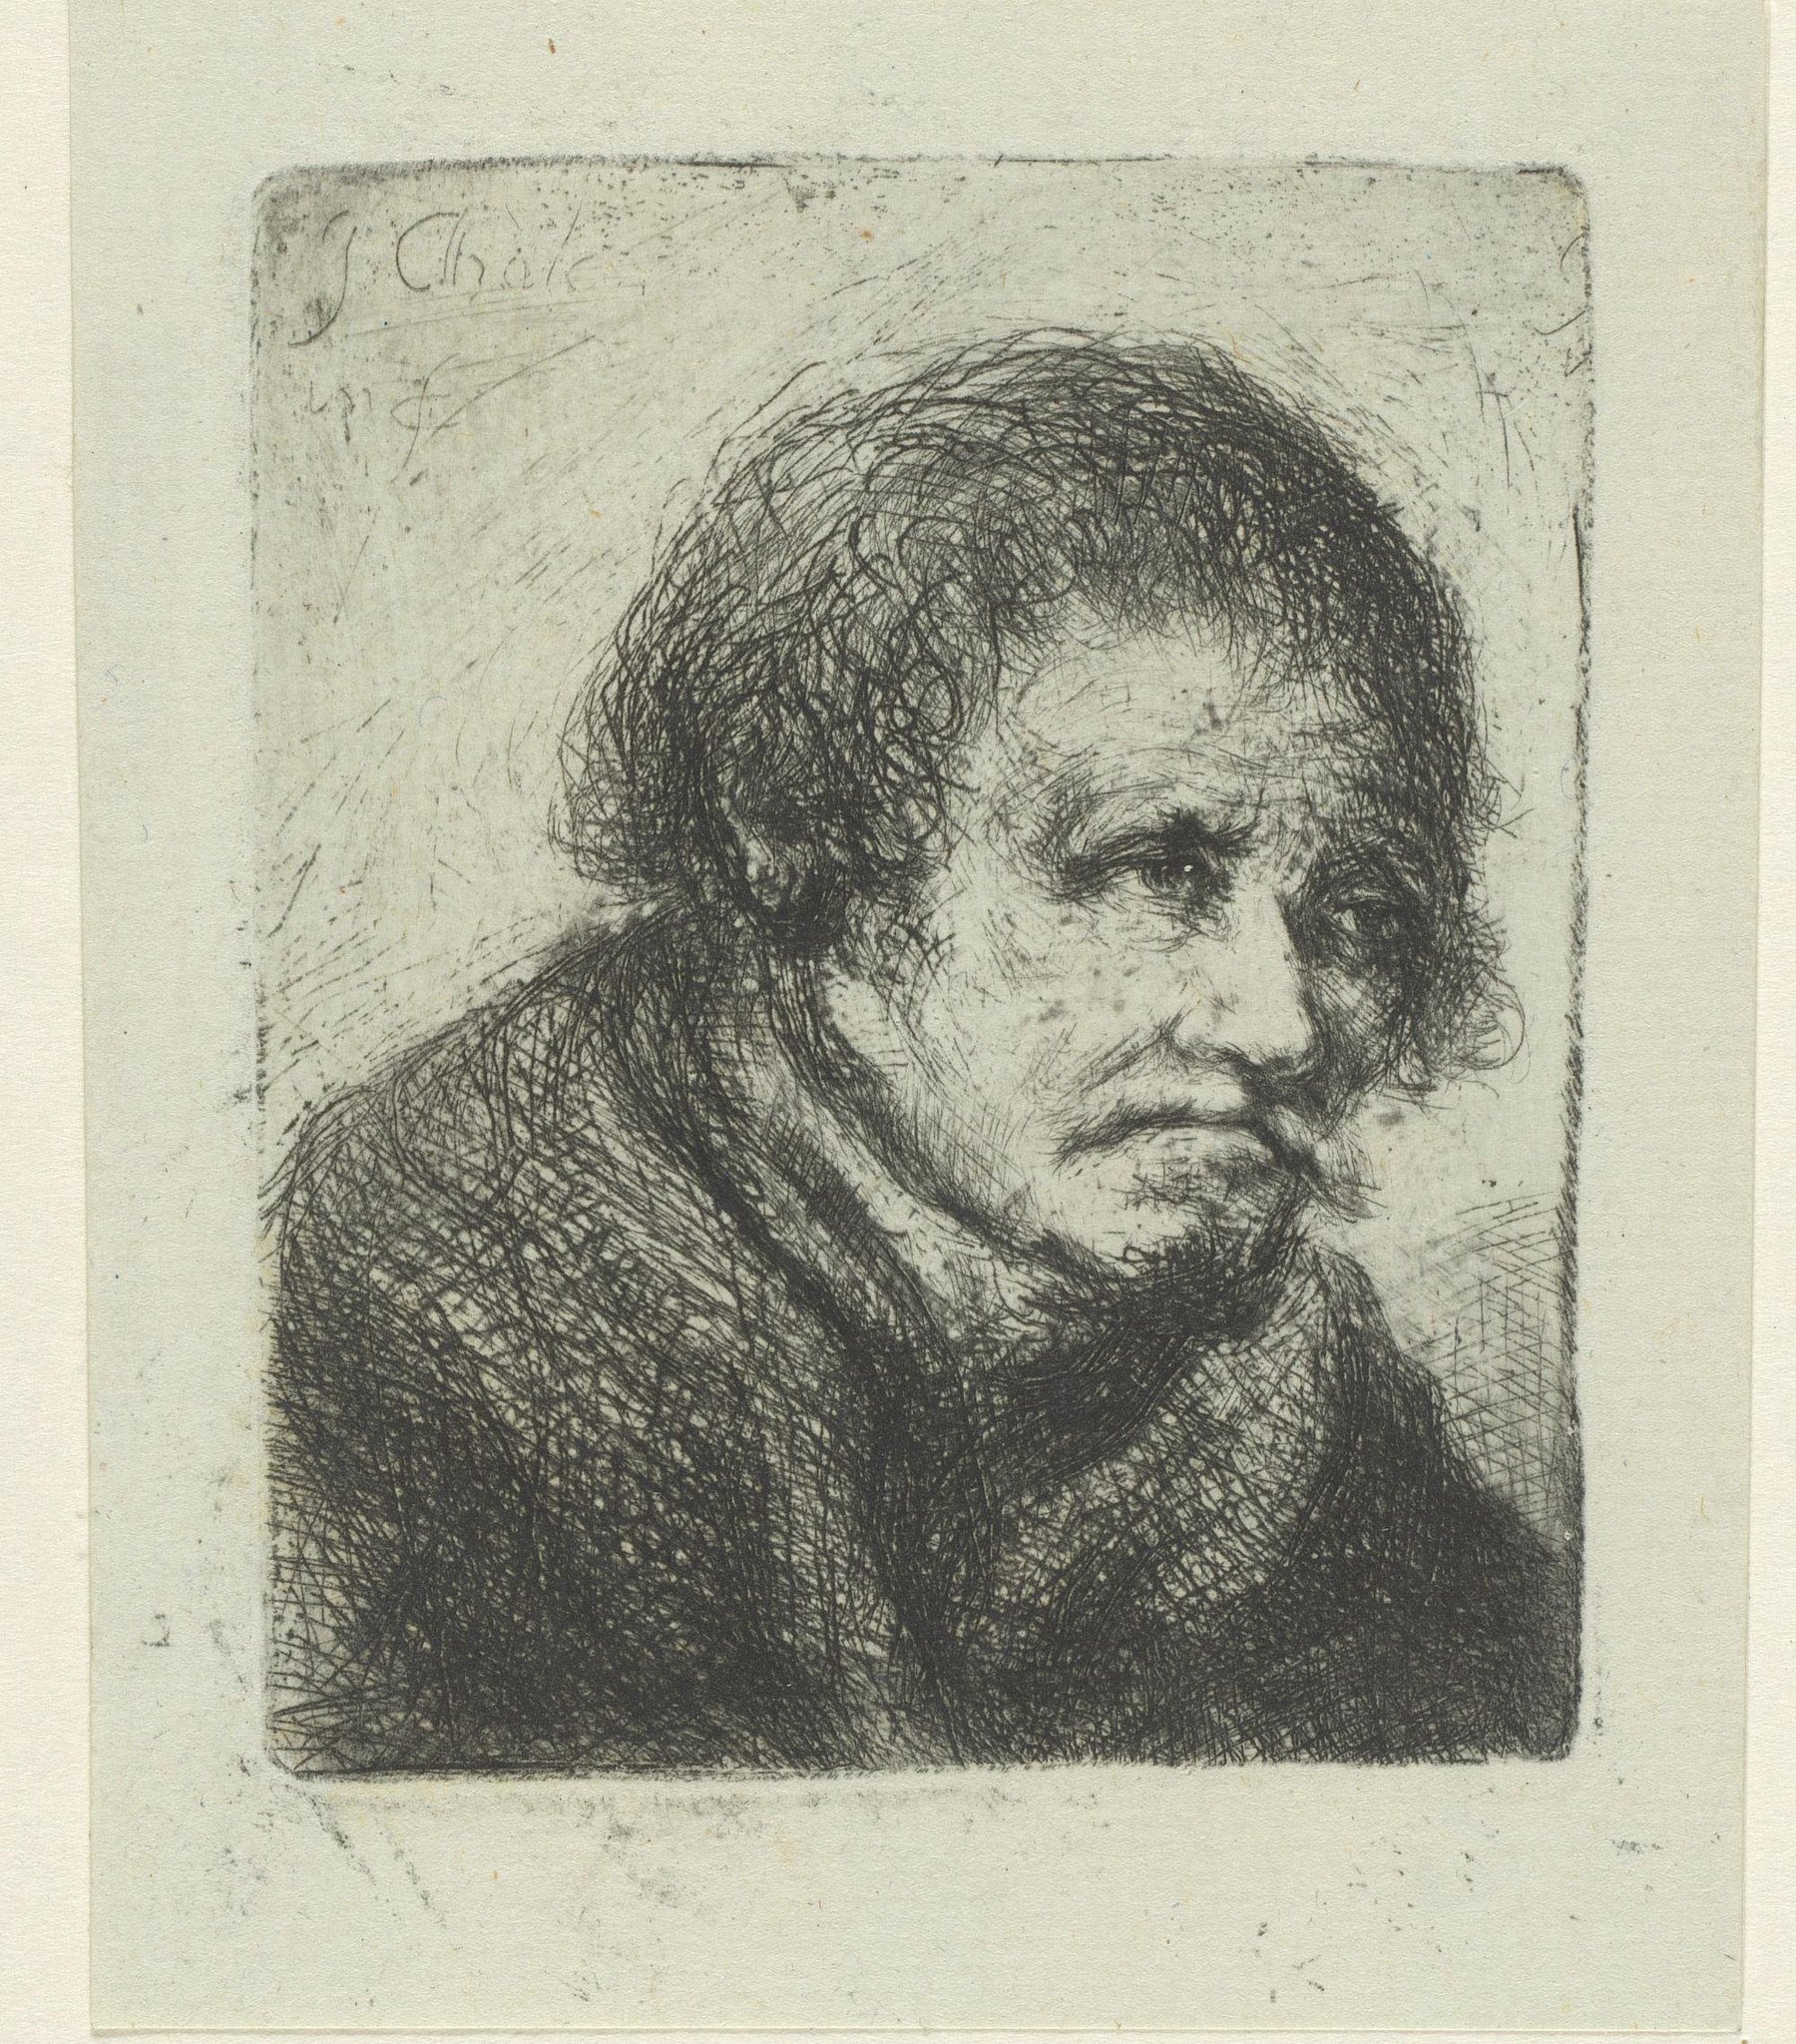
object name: print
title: Volwassen man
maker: jan chalon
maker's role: print maker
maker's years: 1738-1795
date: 1748-1795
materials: paper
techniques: drypoint, etching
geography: northern netherlands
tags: morphology of human expression (+ adult male (human being))